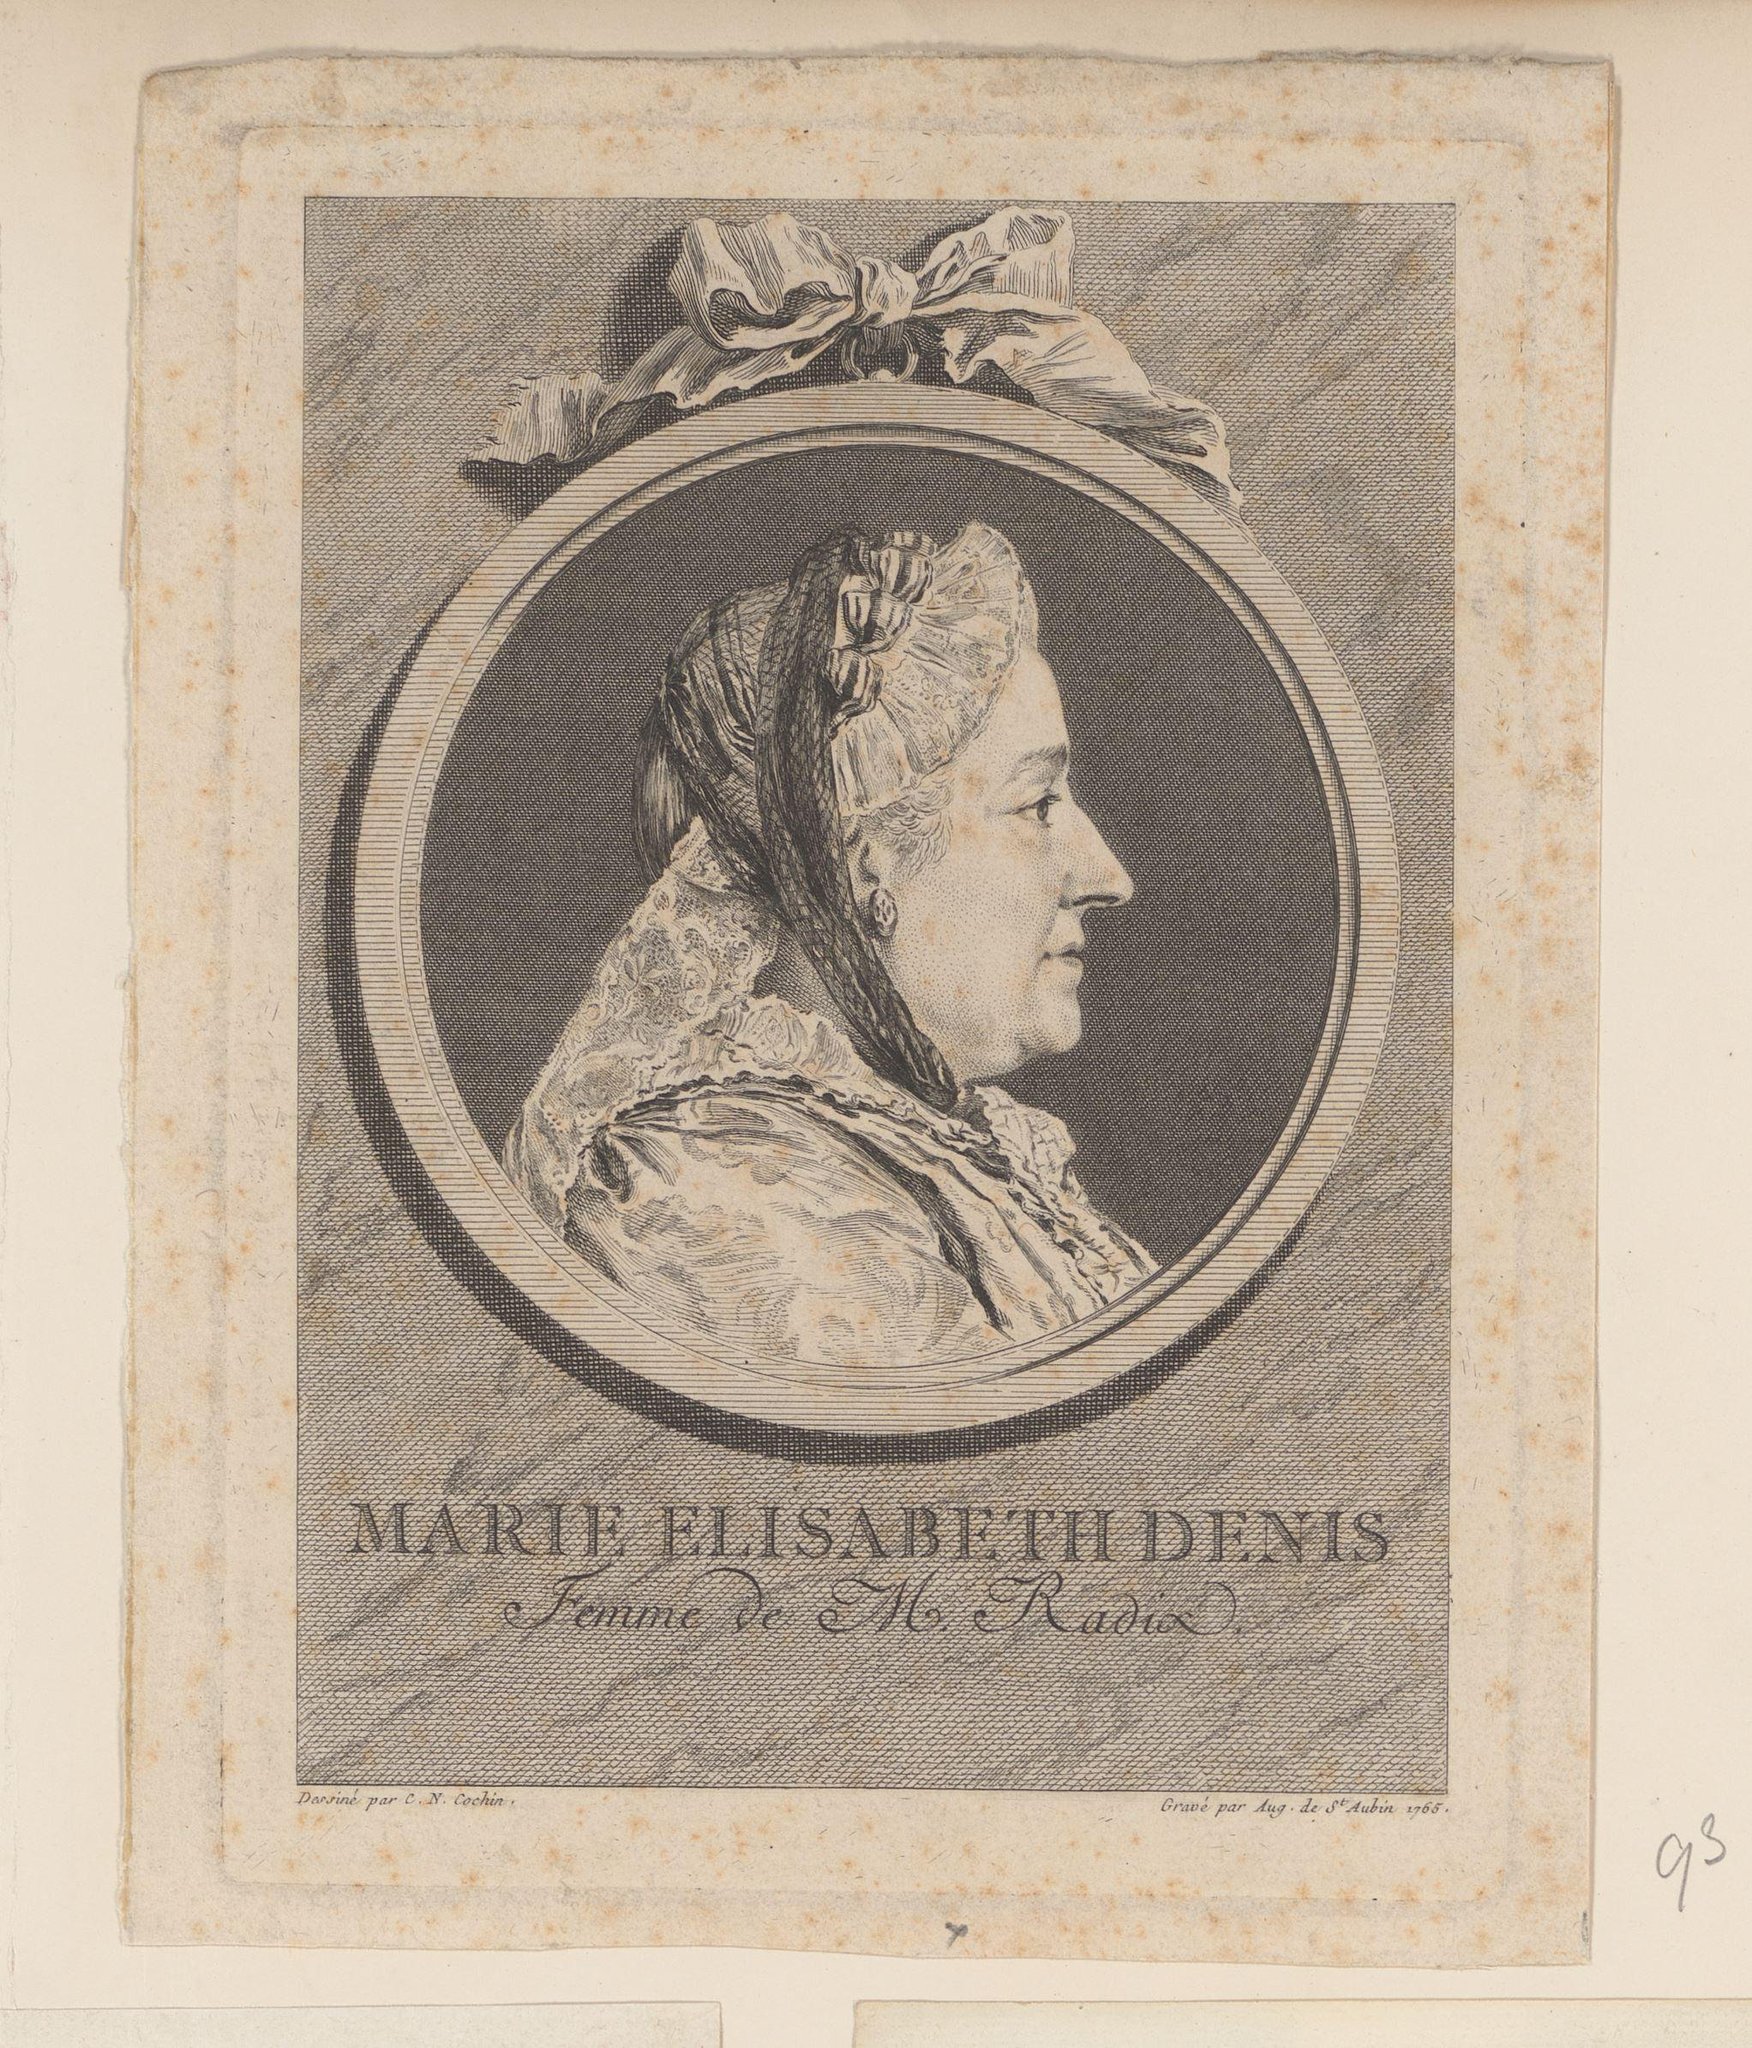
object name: print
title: Portret van Marie Elisabeth Denis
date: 1765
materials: paper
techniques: engraving, etching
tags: historical persons - bb - woman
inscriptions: date